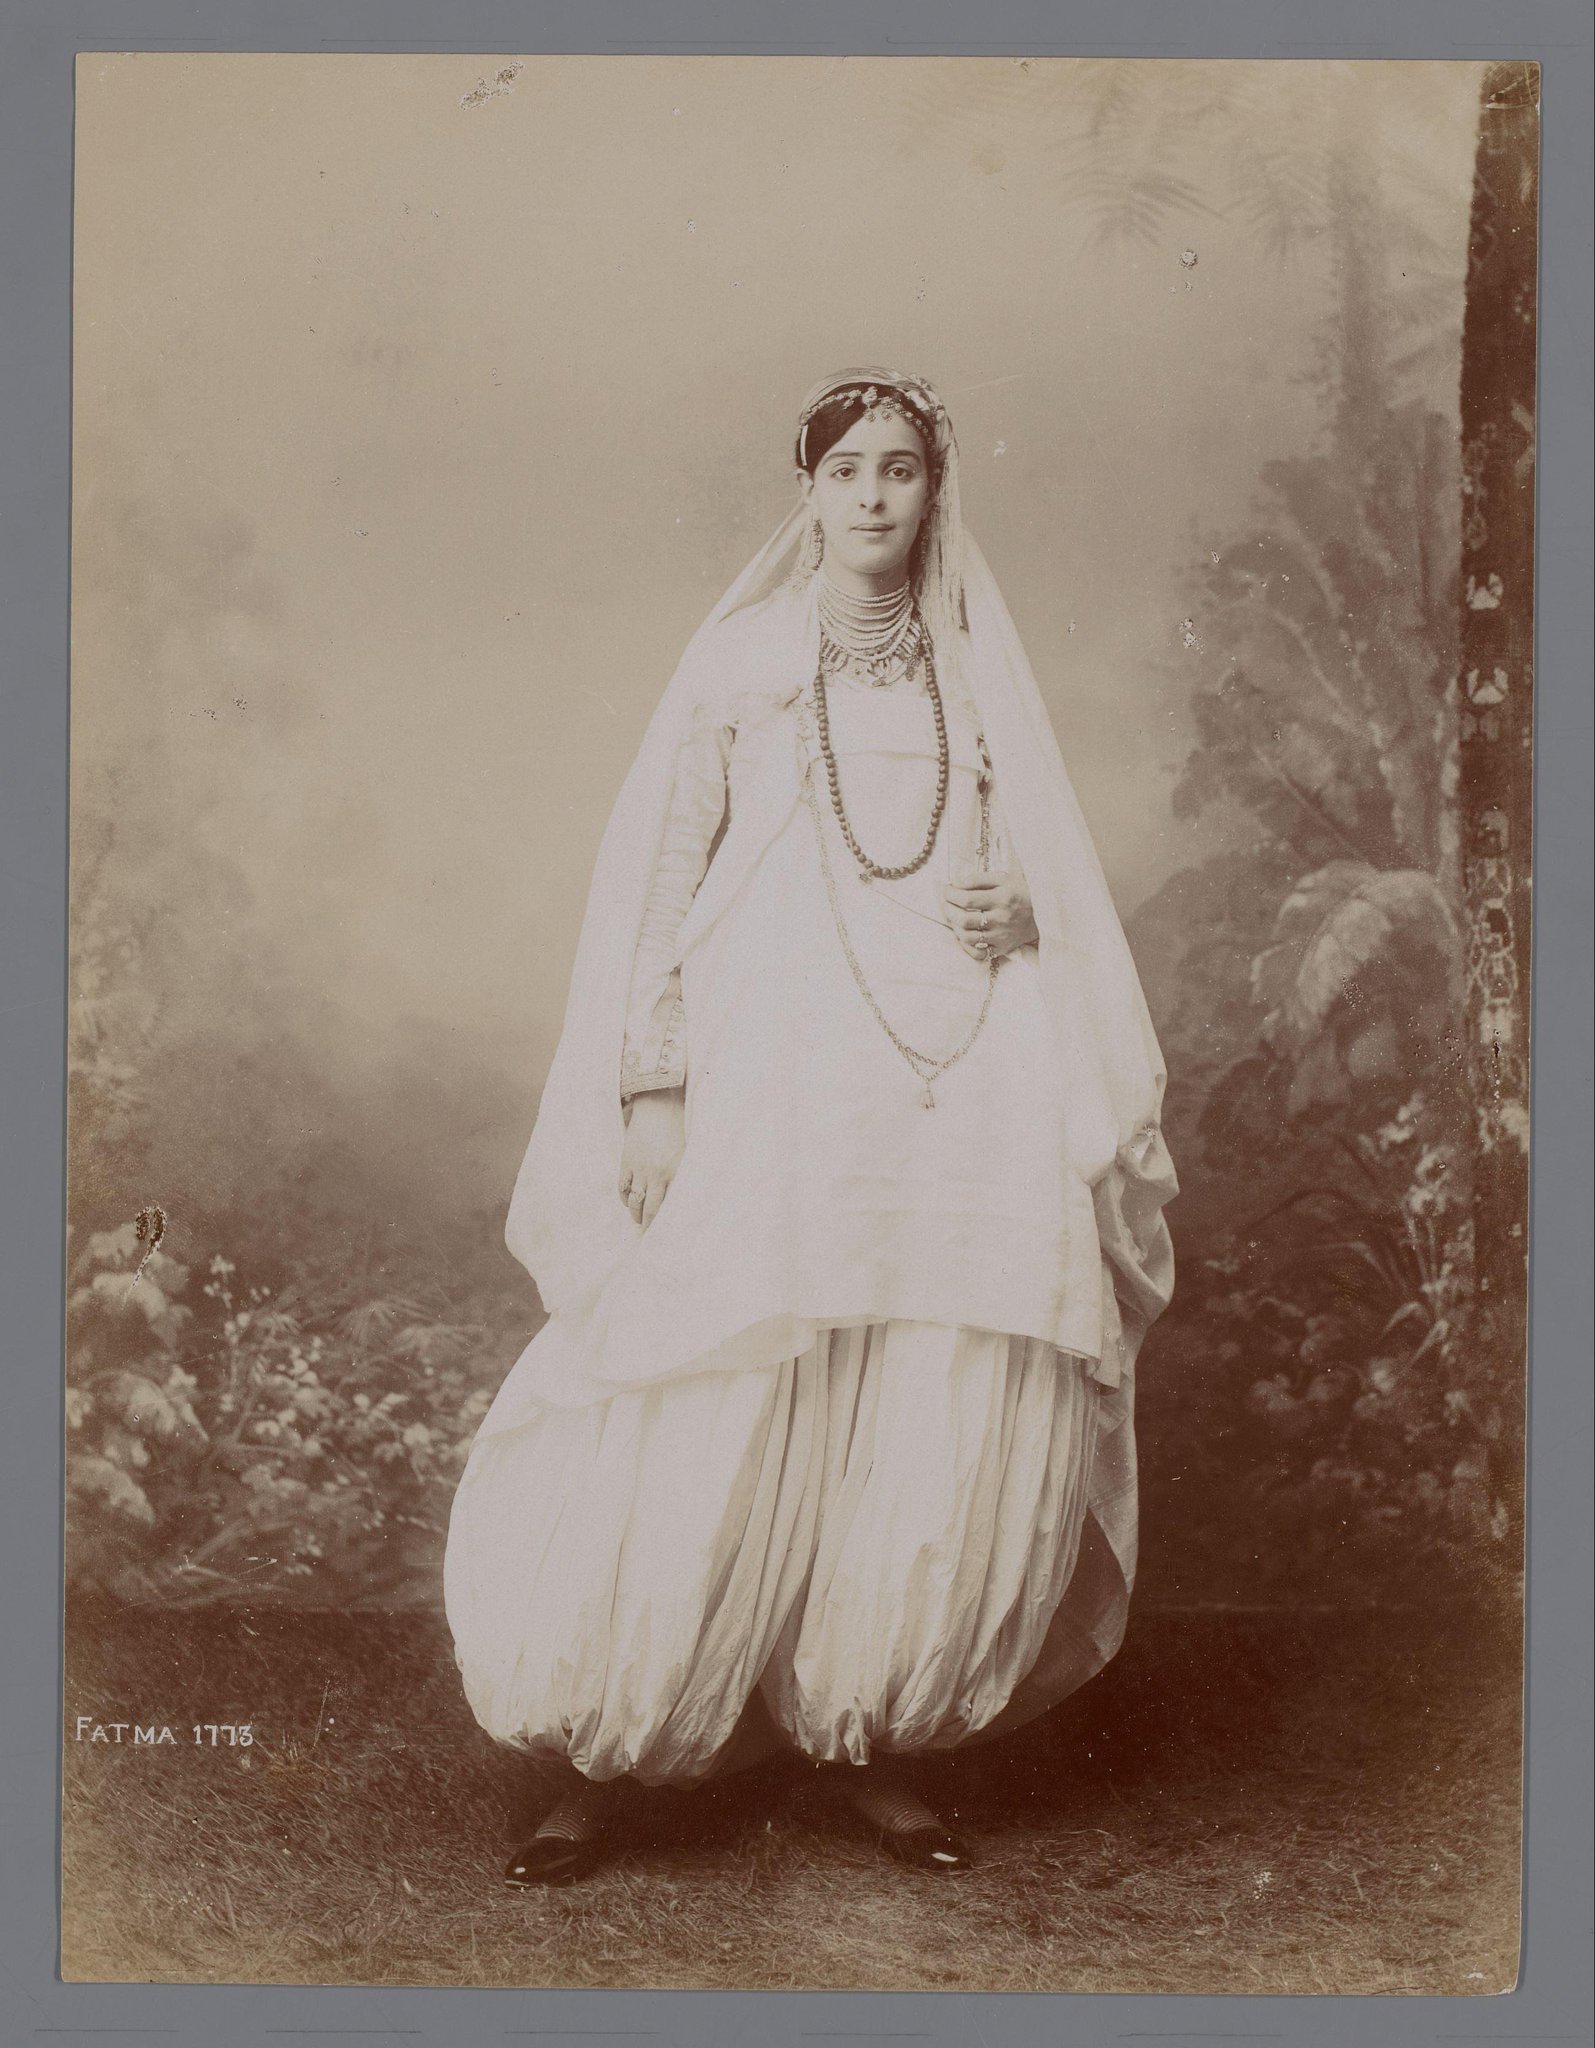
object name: photograph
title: Portret van staande vrouw voor geschilderde achtergrond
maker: Anonymous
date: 1880-1900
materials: paper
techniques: gelatin silver print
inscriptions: inscription: ‘FATMA 1773’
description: Portret van staande vrouw in licht gewaad voor geschilderde achtergrond.